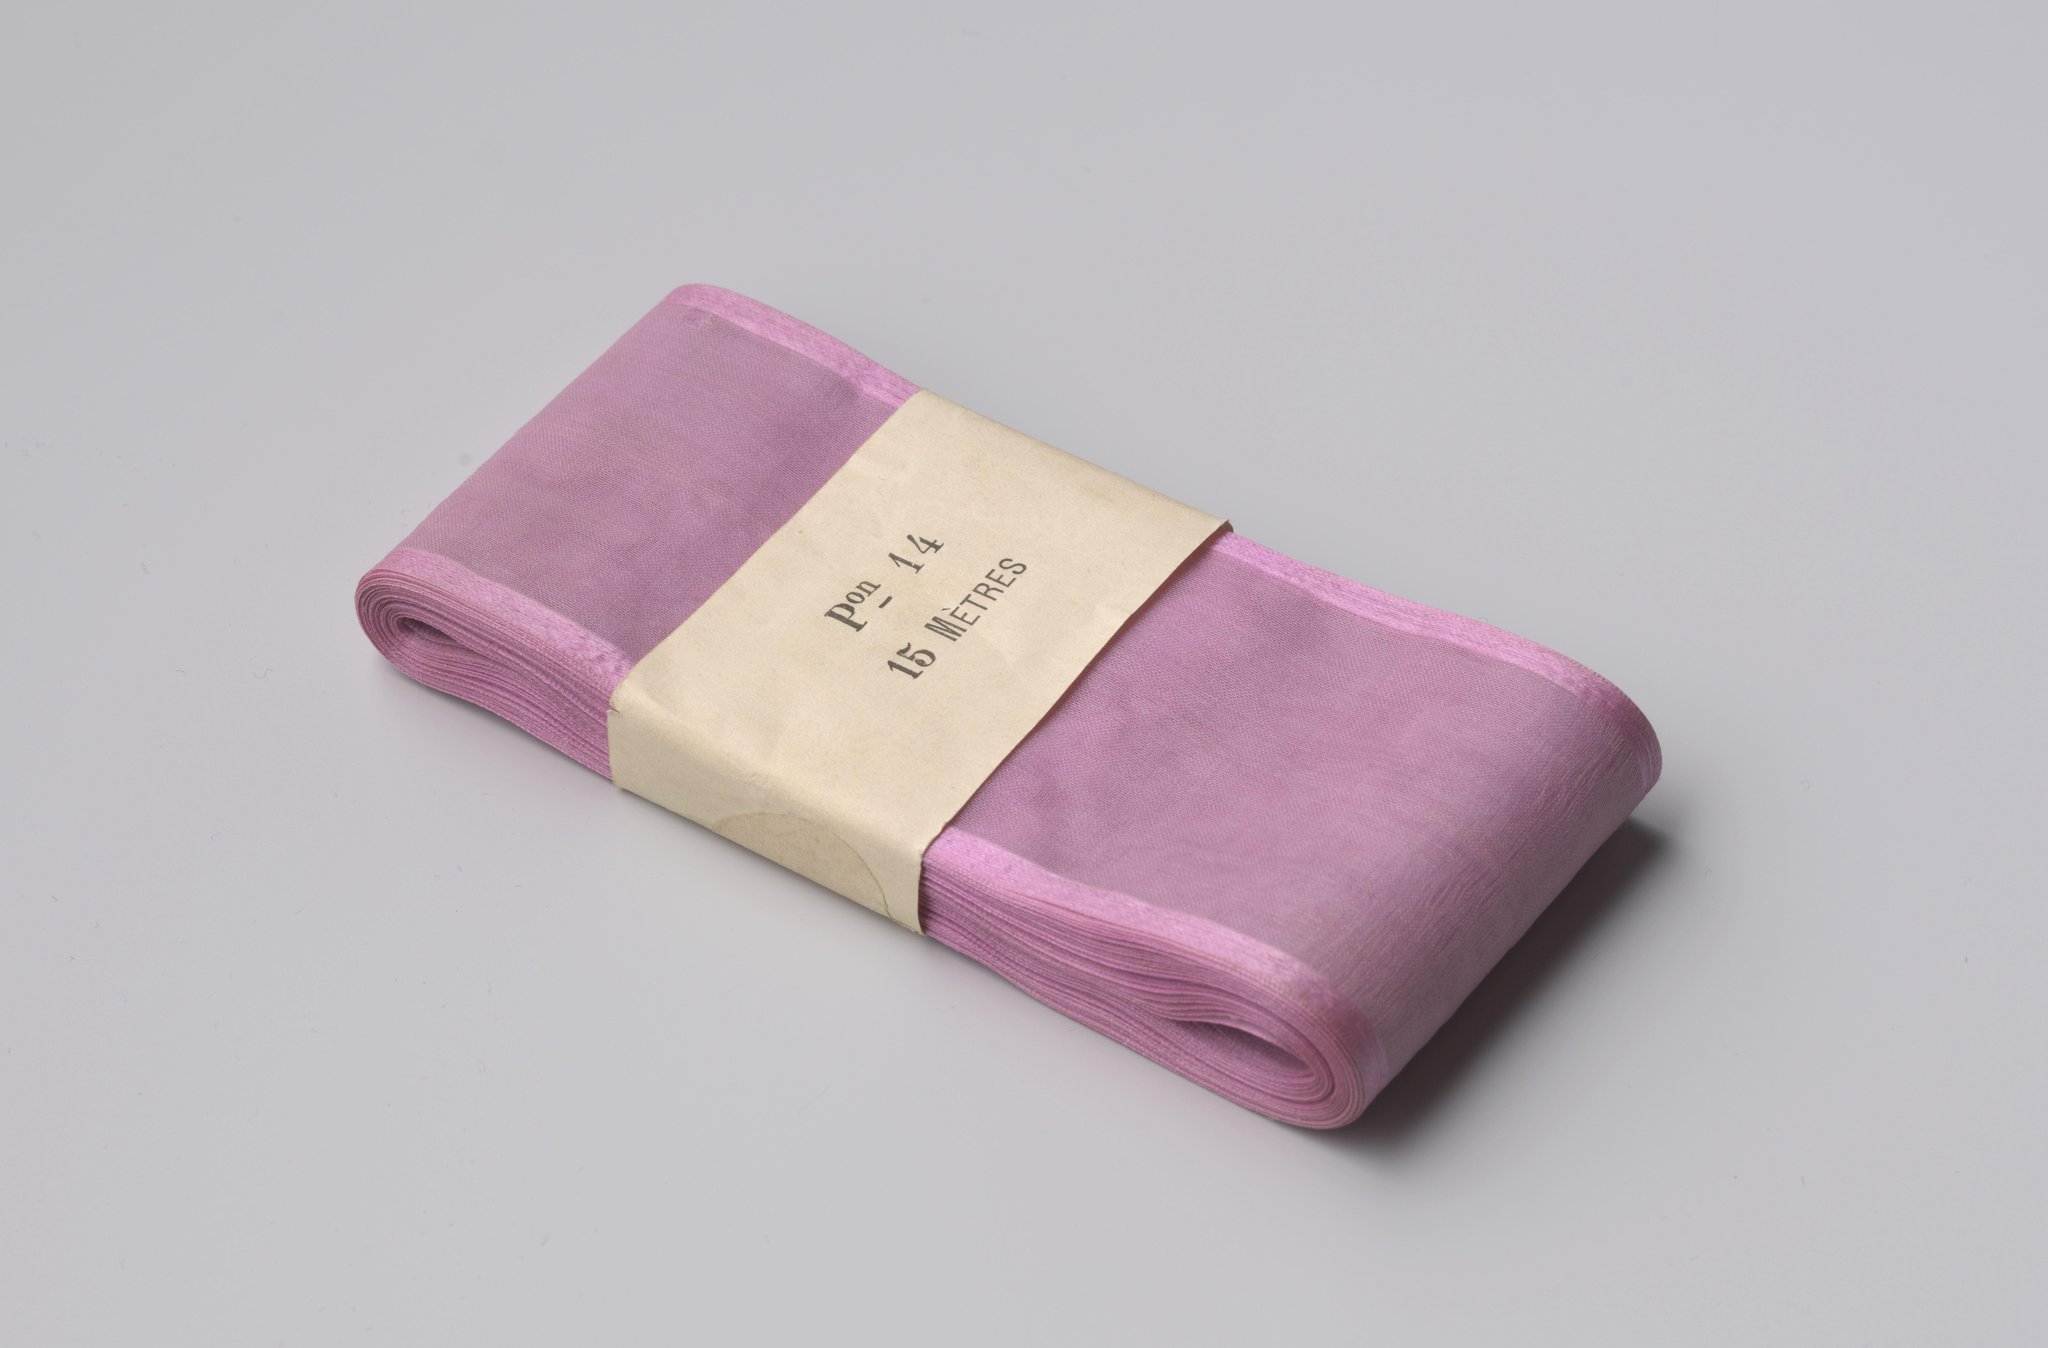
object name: braid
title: Lint van lila gaas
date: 1900-1915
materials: textile, silk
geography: nijmegen